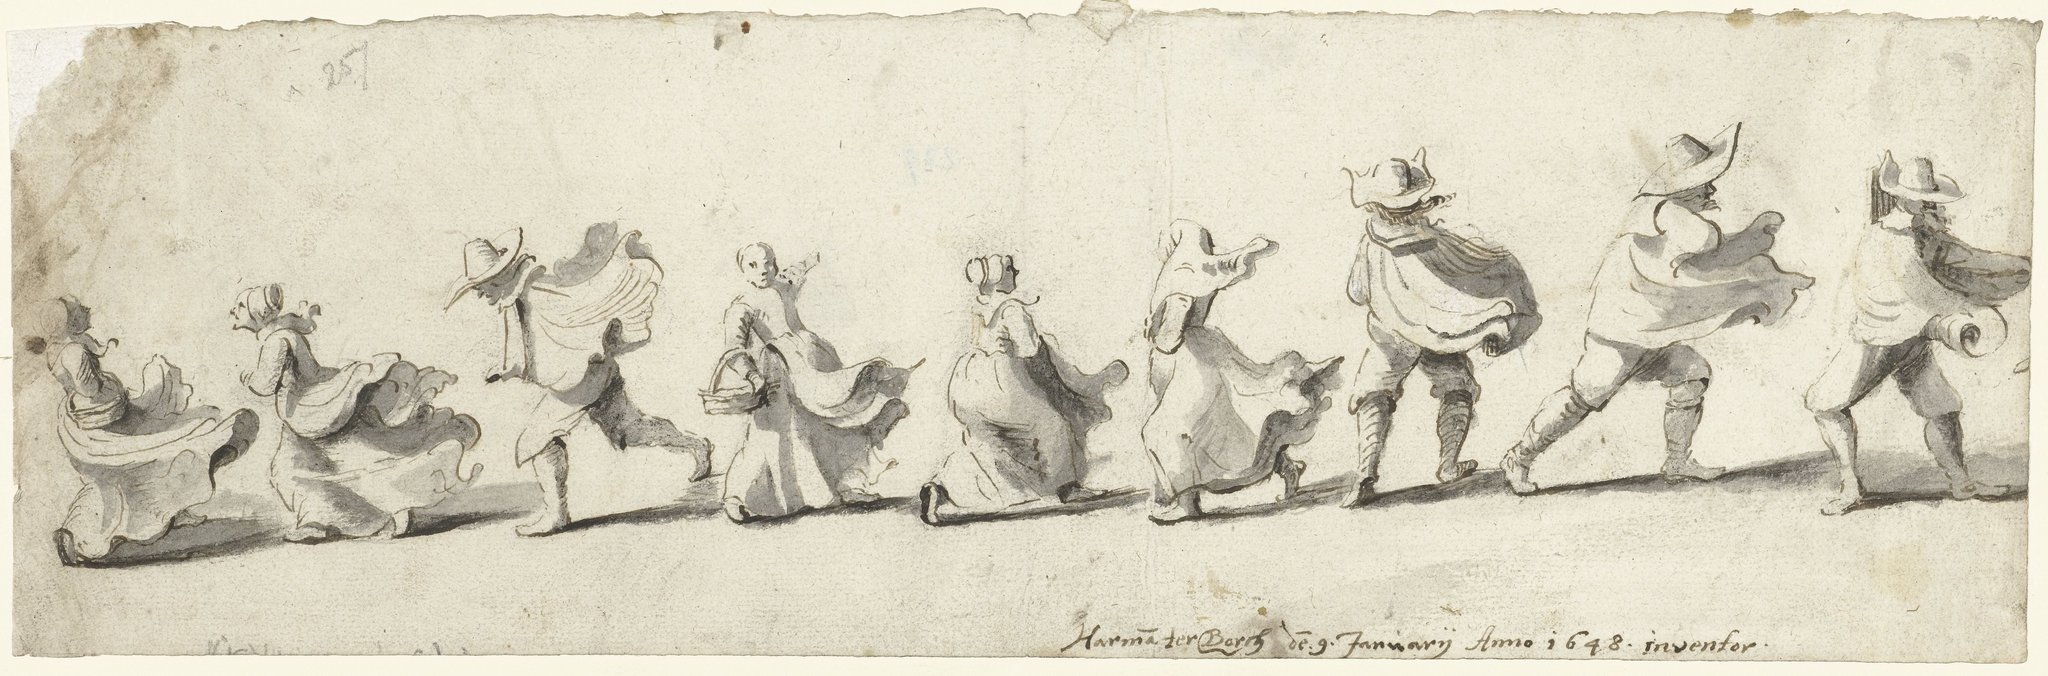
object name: drawing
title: In de wind lopende figuren op een rij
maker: harmen ter borch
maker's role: draughtsman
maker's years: 1638-1677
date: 1648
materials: chalk, ink, paper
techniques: brush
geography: zwolle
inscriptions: annotation: ‘Harma[n] ter Borch de[n].9.January Anno 1648. inventor’